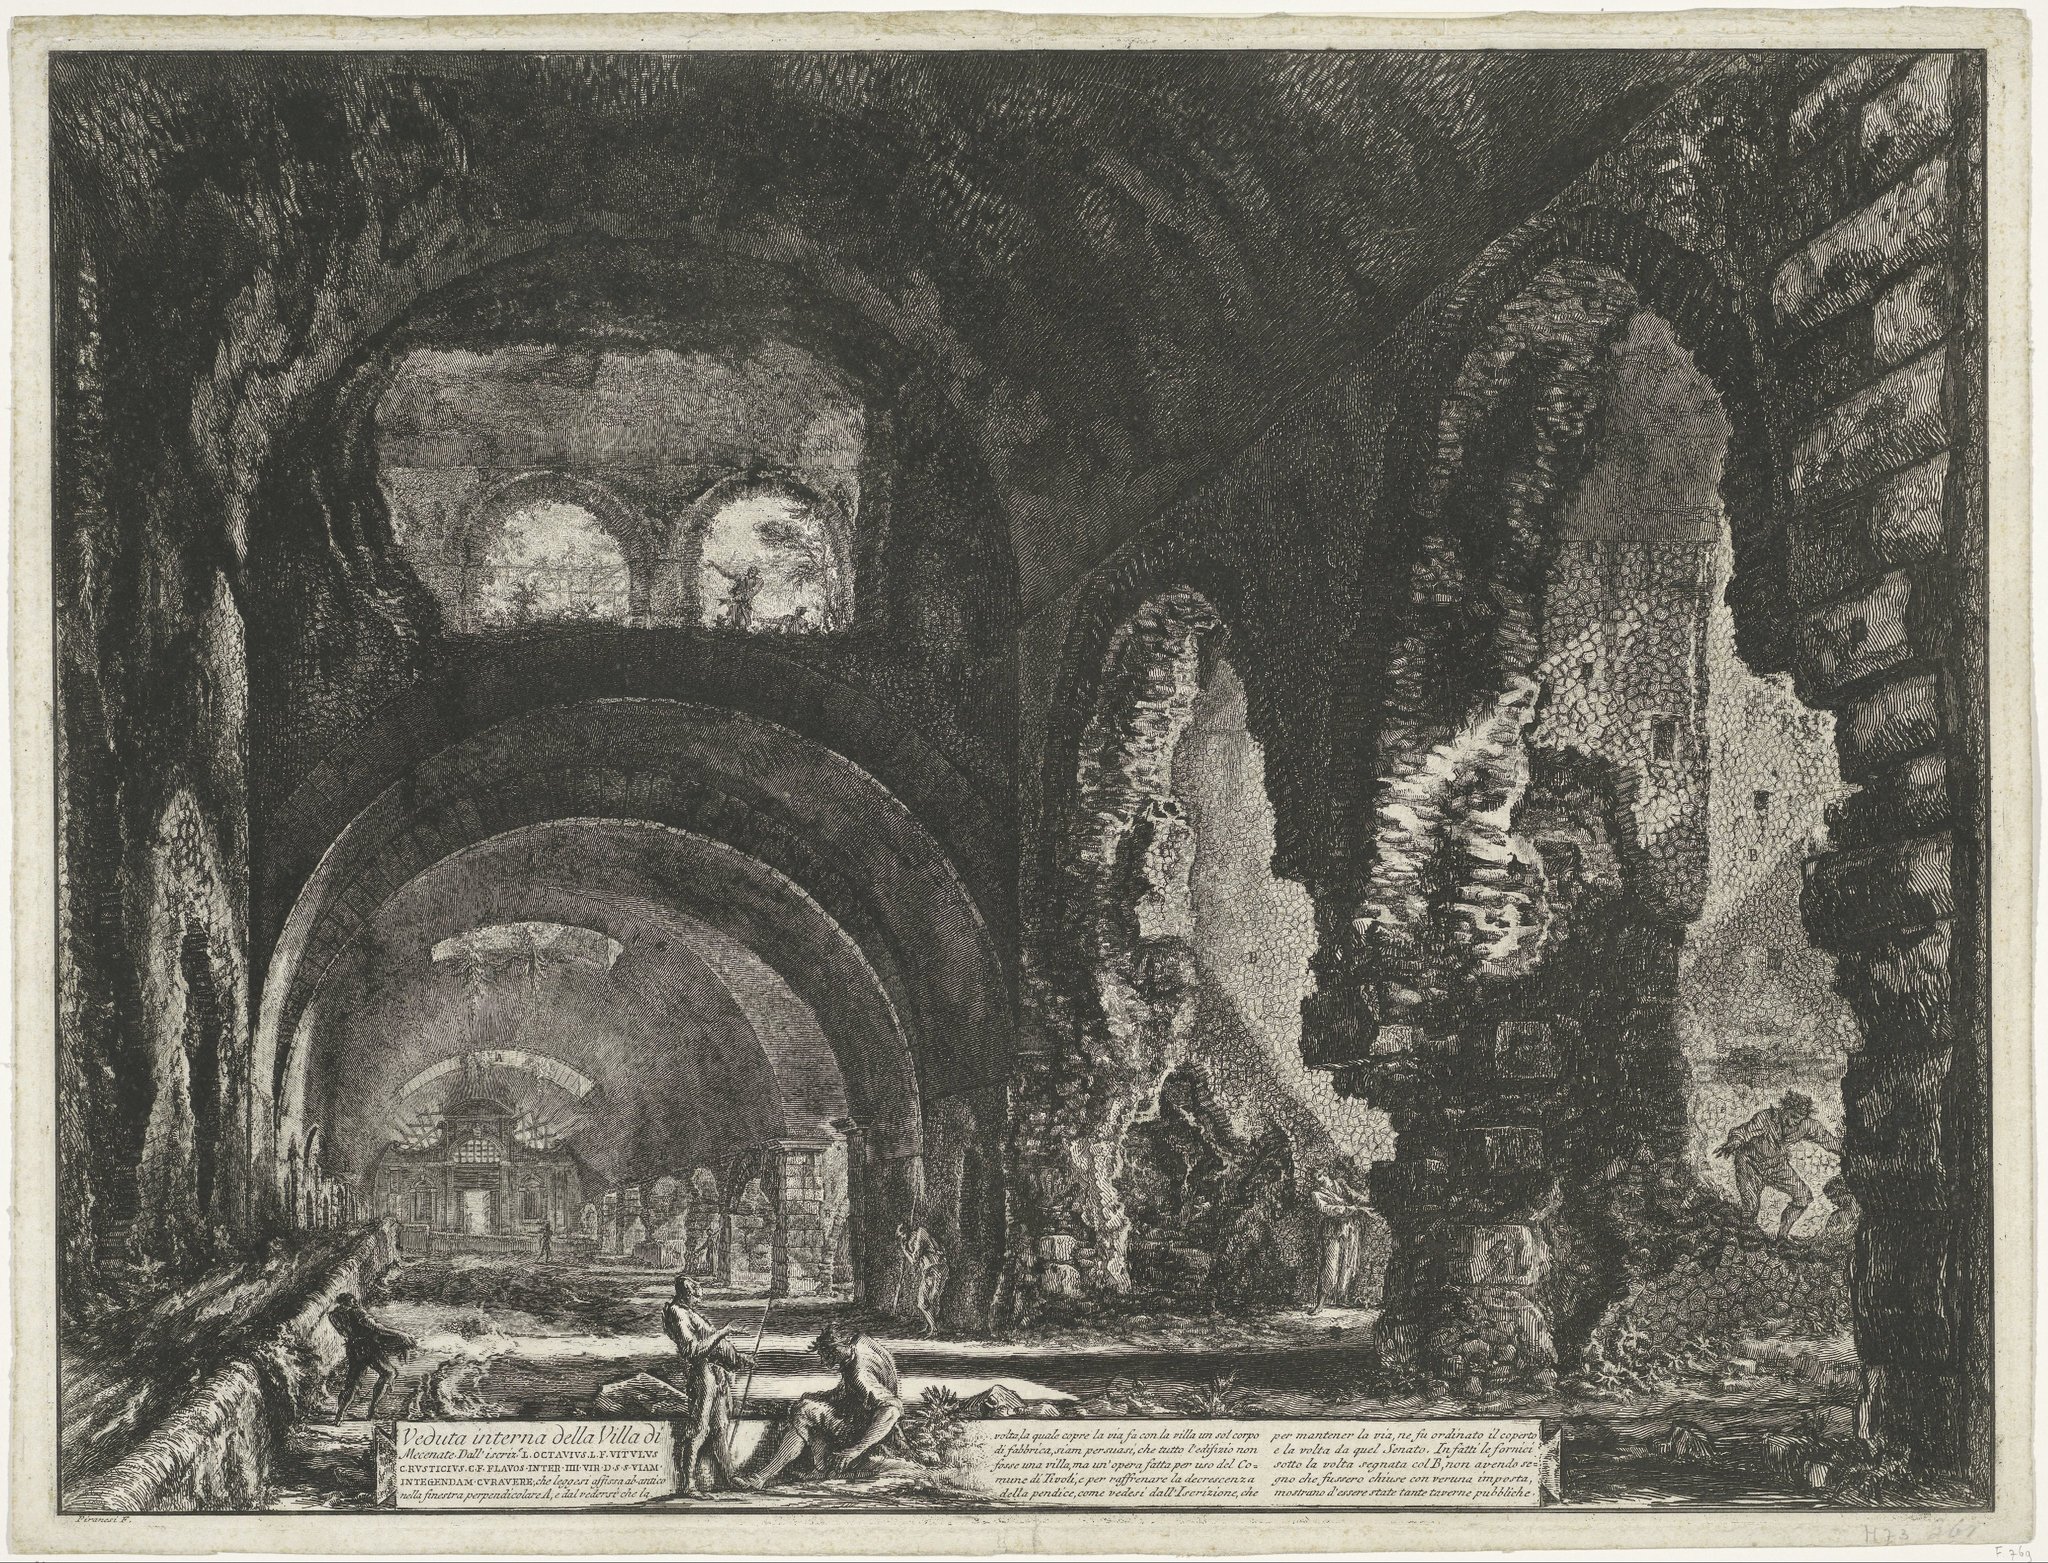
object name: print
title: Veduta interna della Villa di Mecenate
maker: giovanni battista piranesi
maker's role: designer, draughtsman, print maker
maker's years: 1720-1778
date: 1748-1778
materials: paper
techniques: etching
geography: rome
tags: ruin of a building ~ architecture, temple, shrine ~ roman religion, temple of hercules victor, tivoli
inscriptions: collector's mark: Lugt 2228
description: Deze prent maakt deel uit van de serie 'Vedute di Roma'. Piranesi werkte aan deze 135 platen tellende serie tussen 1748 en zijn dood in 1778. Francesco Piranesi voegde later nog twee prenten toe aan de reeks van zijn vader.